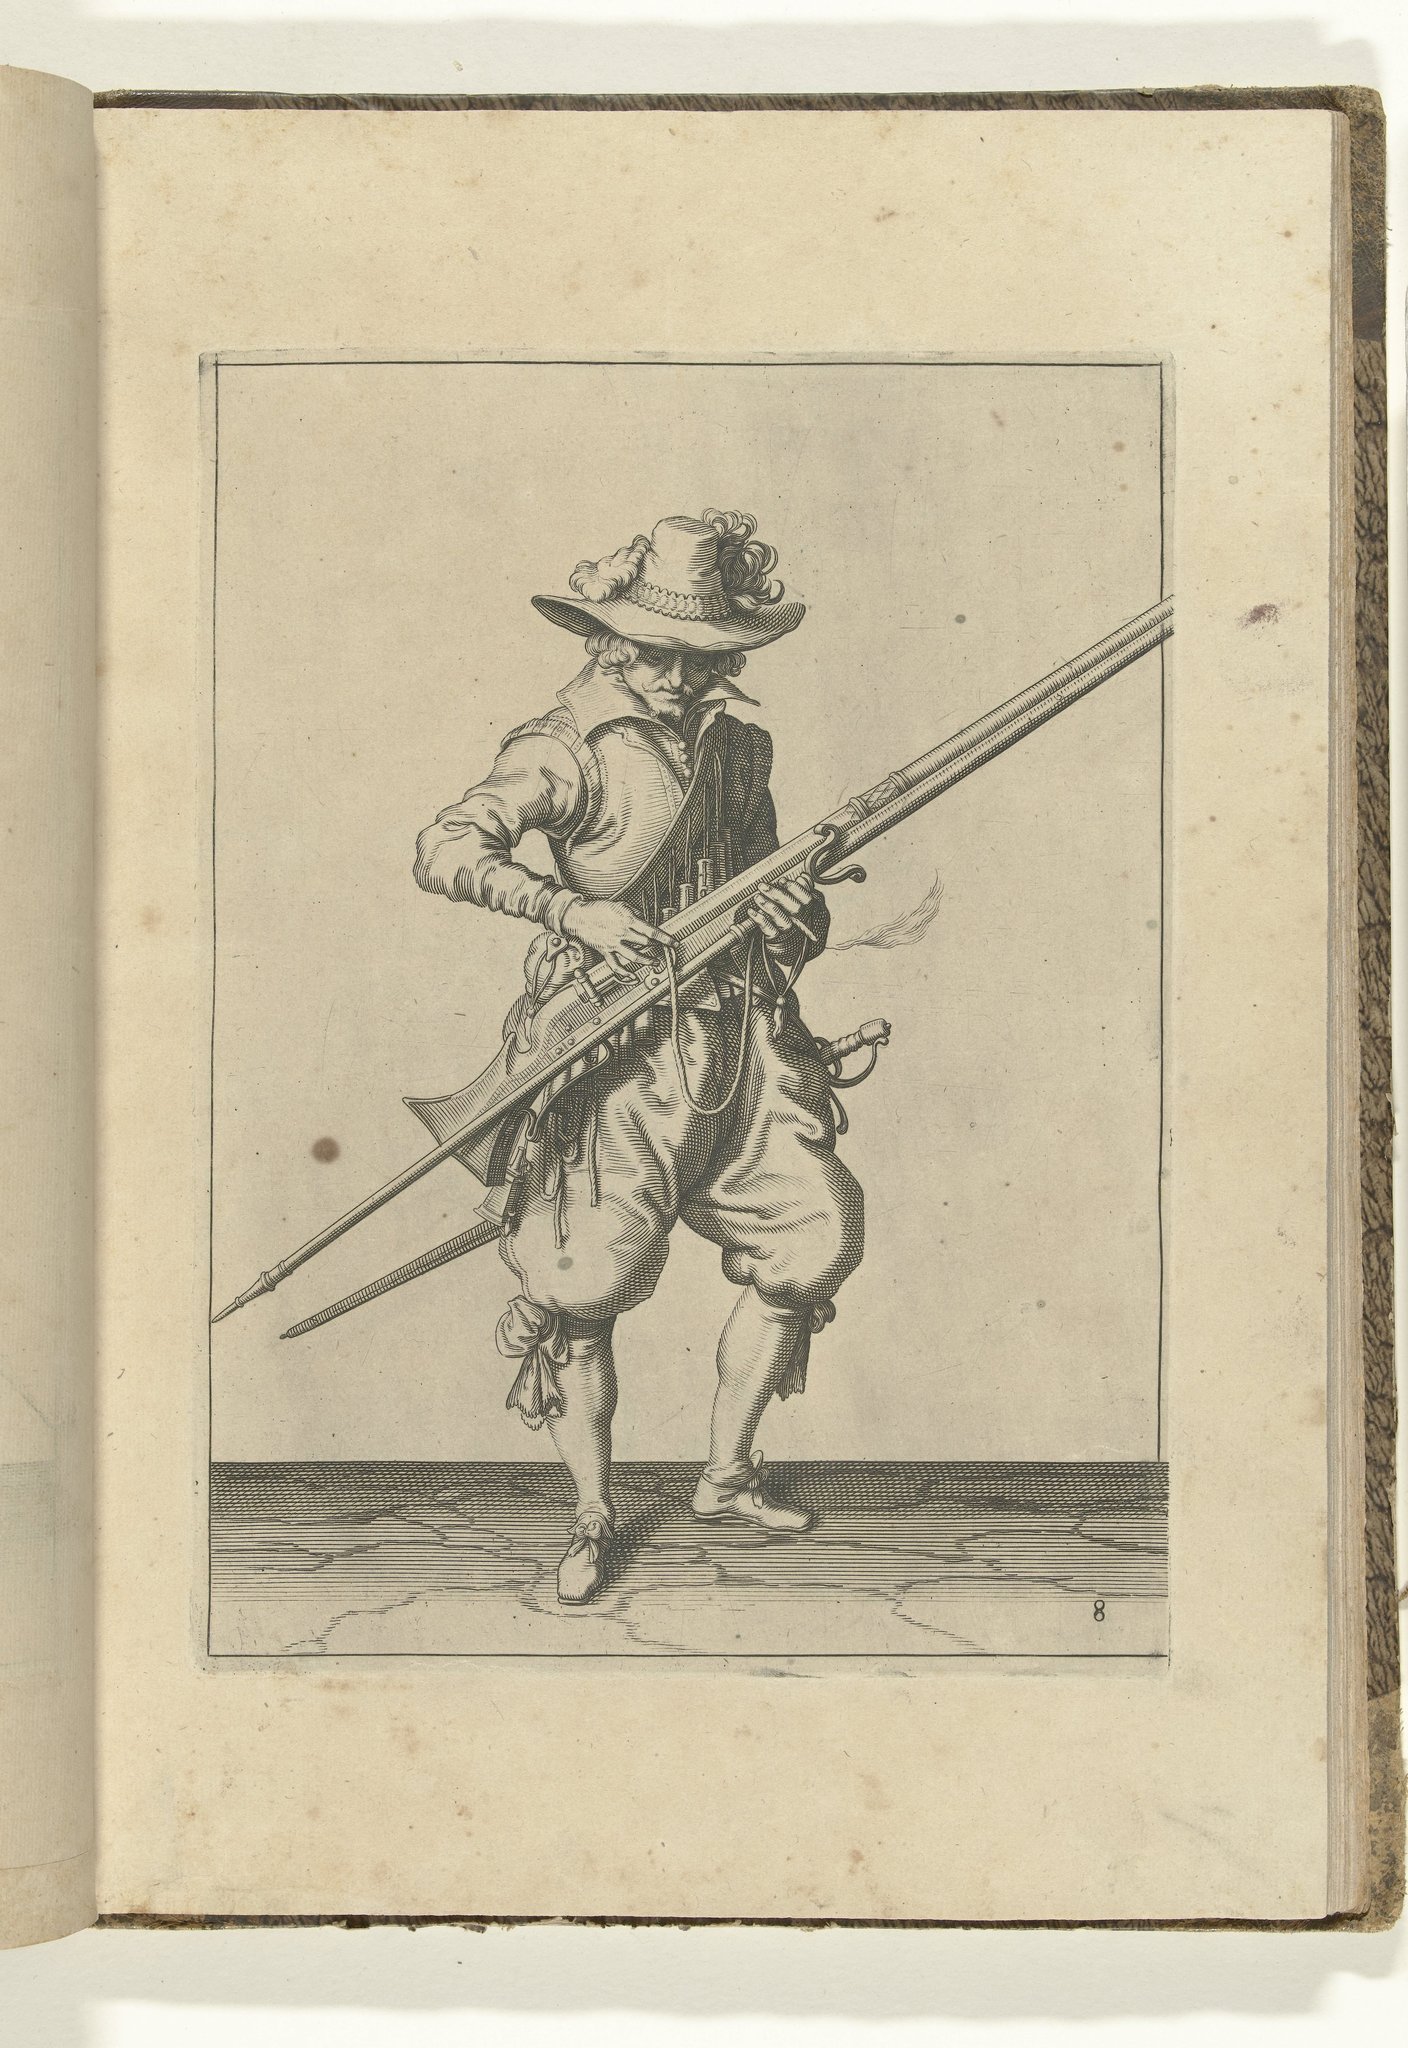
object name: print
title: Soldaat die zijn lont op de haan van zijn musket drukt (nr. 8), ca. 1600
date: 1597-1608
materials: paper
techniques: engraving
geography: amsterdam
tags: the hague, maurice (prince of orange), handling of weapons ~ military training, weapons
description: Een soldaat, ten voeten uit, naar rechts, die een musket (een bepaald type vuurwapen) met zijn linkerhand vasthoudt (nr. 8), ca. 1600. Met zijn rechterhand drukt hij een brandende lont op de haan (onderdeel van het ontstekingsmechanisme) van zijn musket. Plaat 8 in de instructies voor het hanteren van het musket: Brief enseignement, sur les pourtraitz figurez, touchant le droit maniement du Mousquet. Onderdeel van de illustraties in een Franse editie van J. de Gheyns Wapenhandelinghe: J. de Gheyn, Maniement d'armes, d'arquebuses, mousquetz et piques : en conformité de l'ordre de Mour le Prince Maurice, Prince d'Orange, Amsterdam 1608. Krijgswezen rond 1600.